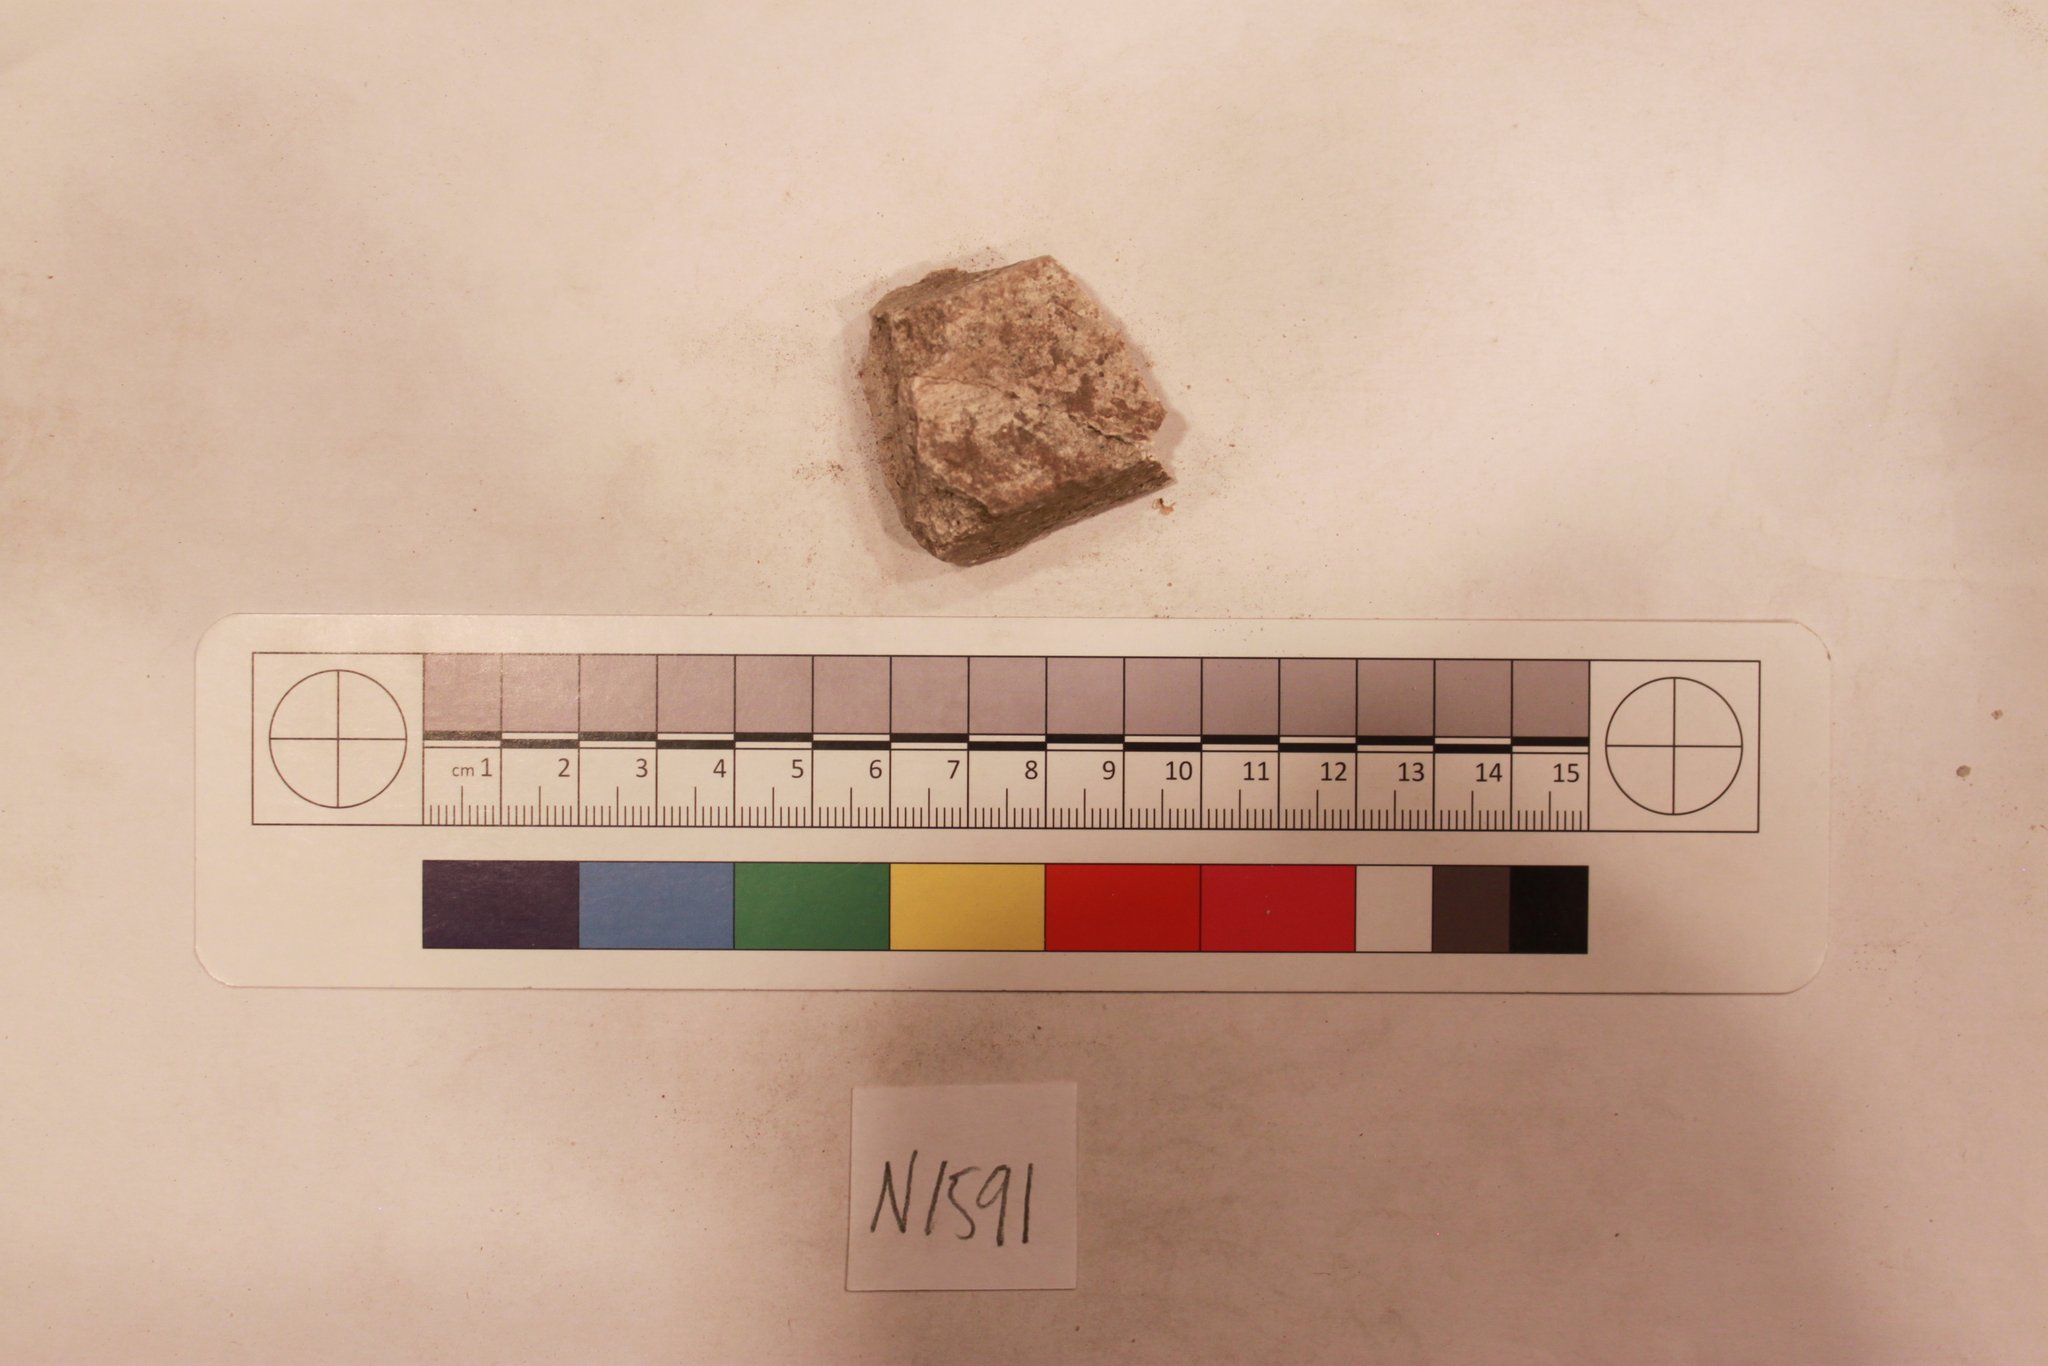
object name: fragment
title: Stucco Fragment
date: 701-1200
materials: plaster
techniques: carving, painting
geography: iran